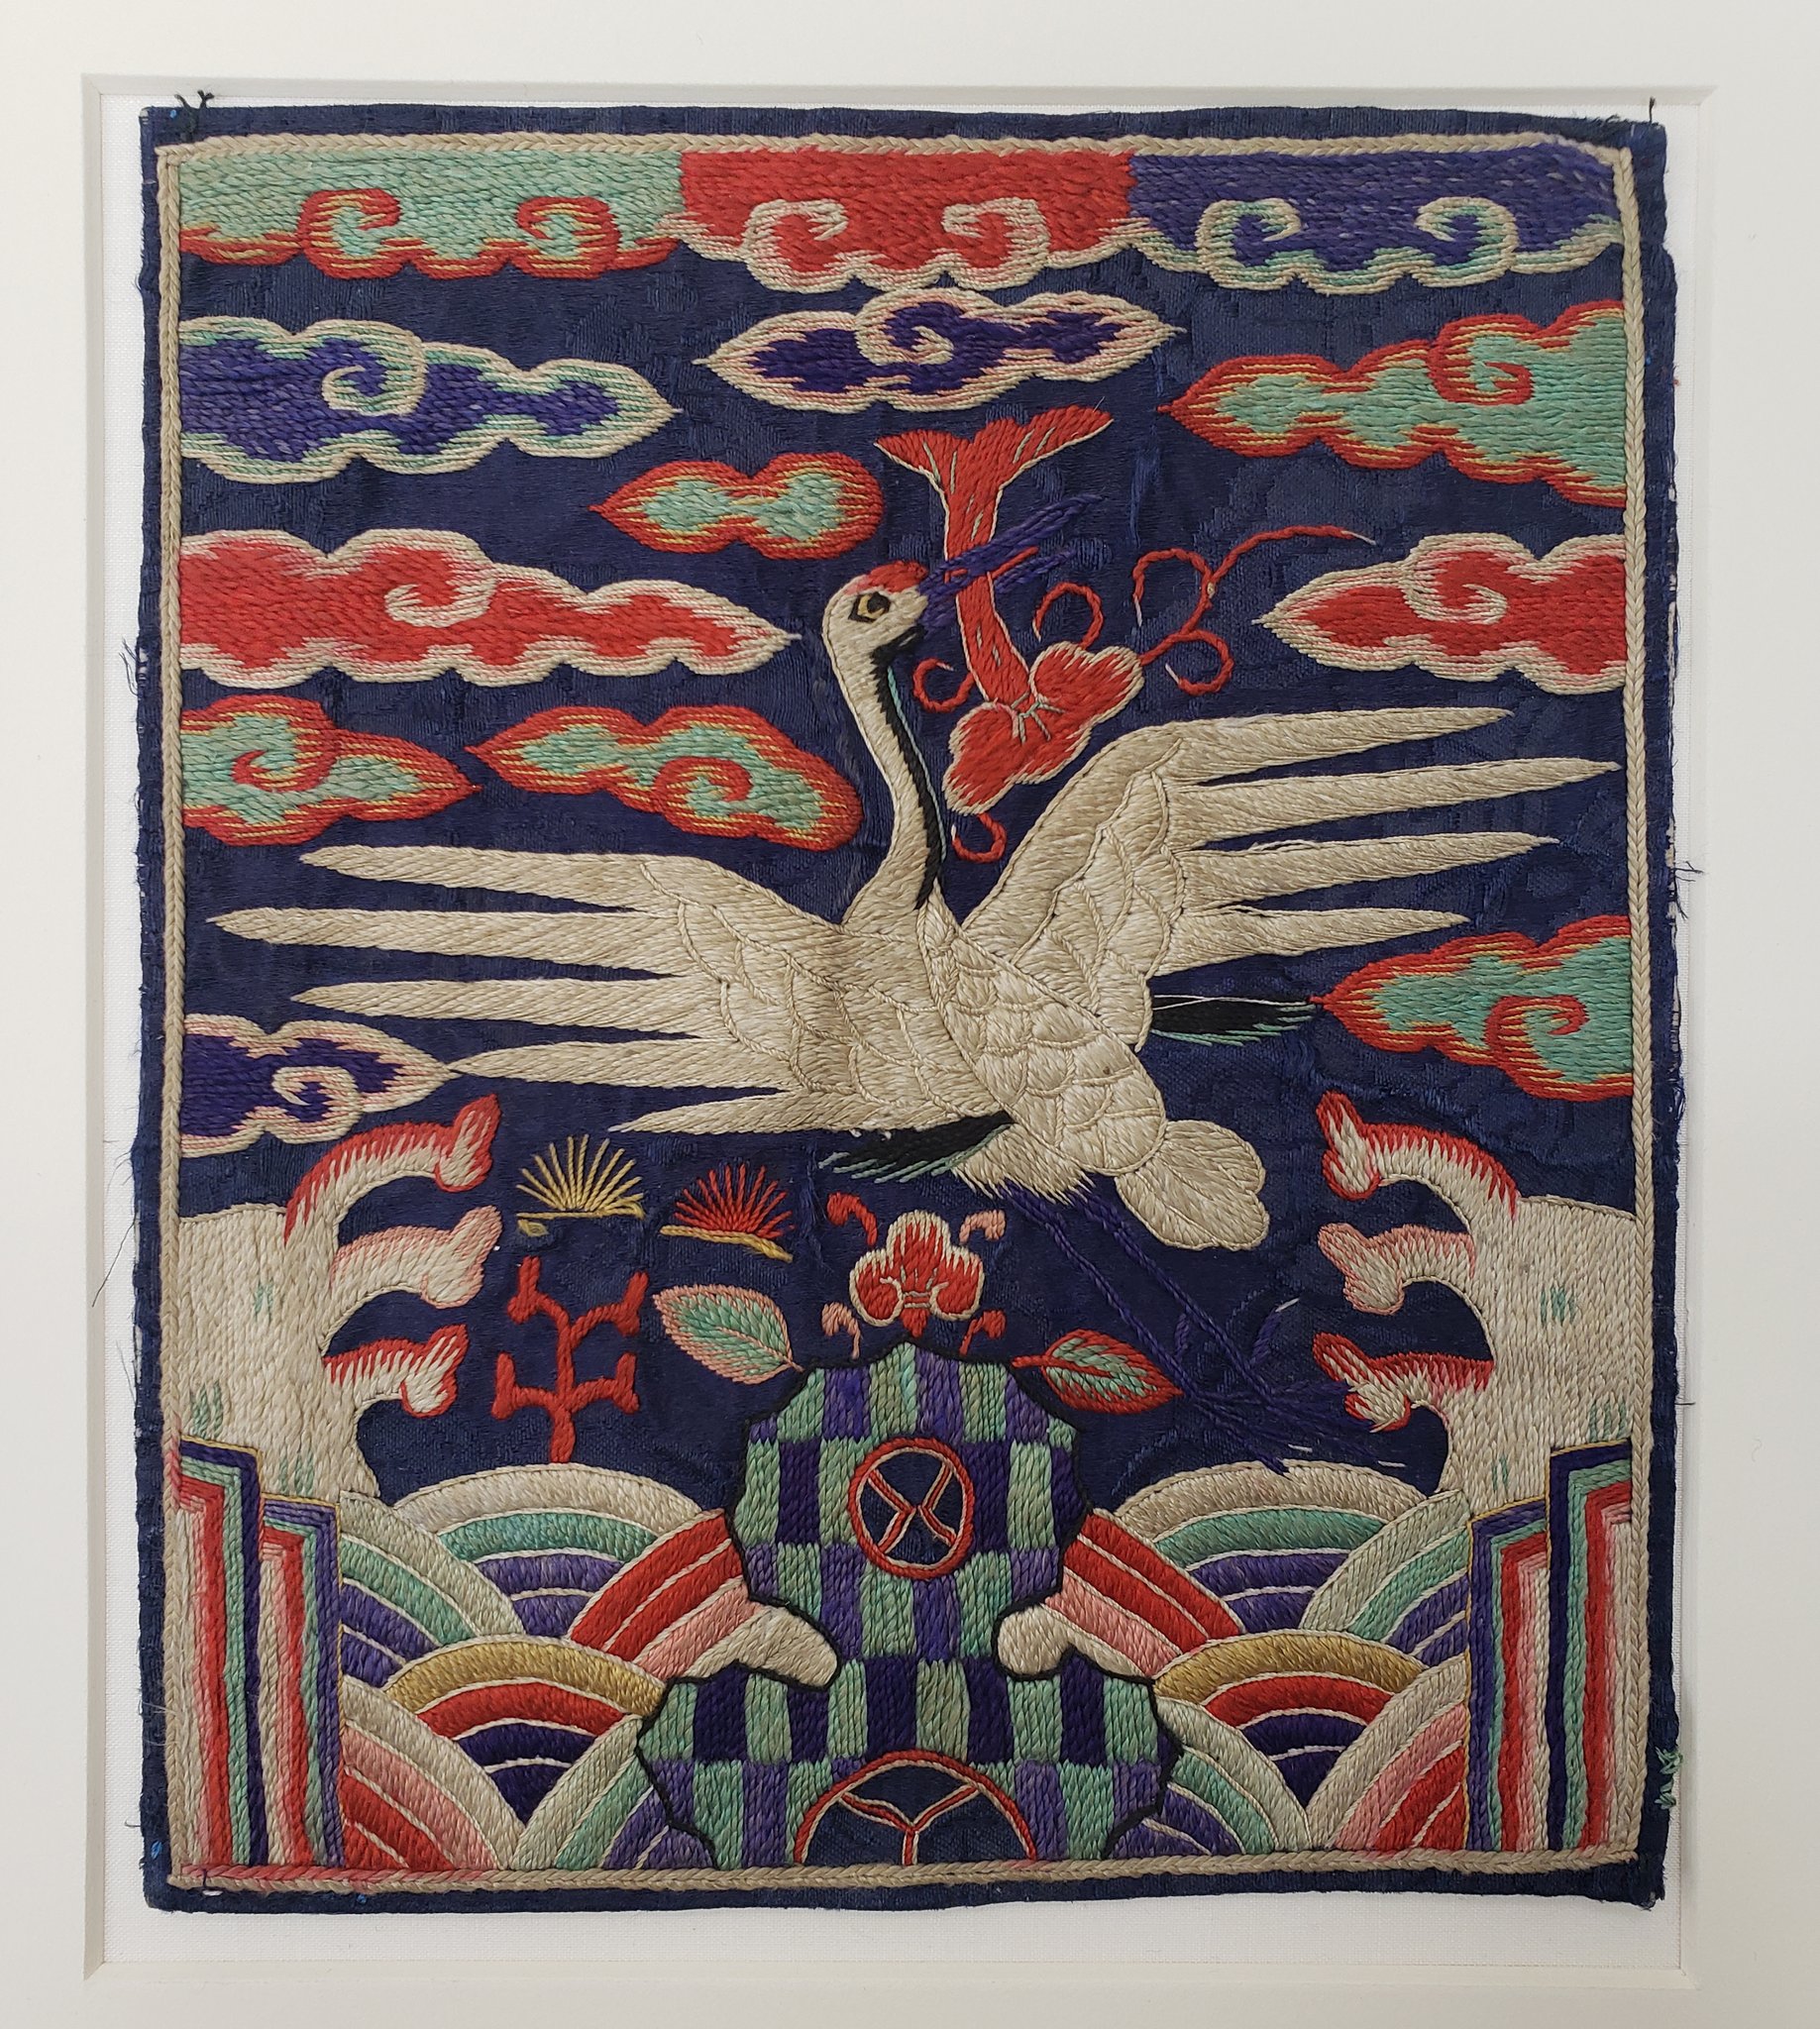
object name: rank badge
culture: korean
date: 1392-1910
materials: silk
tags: cranes